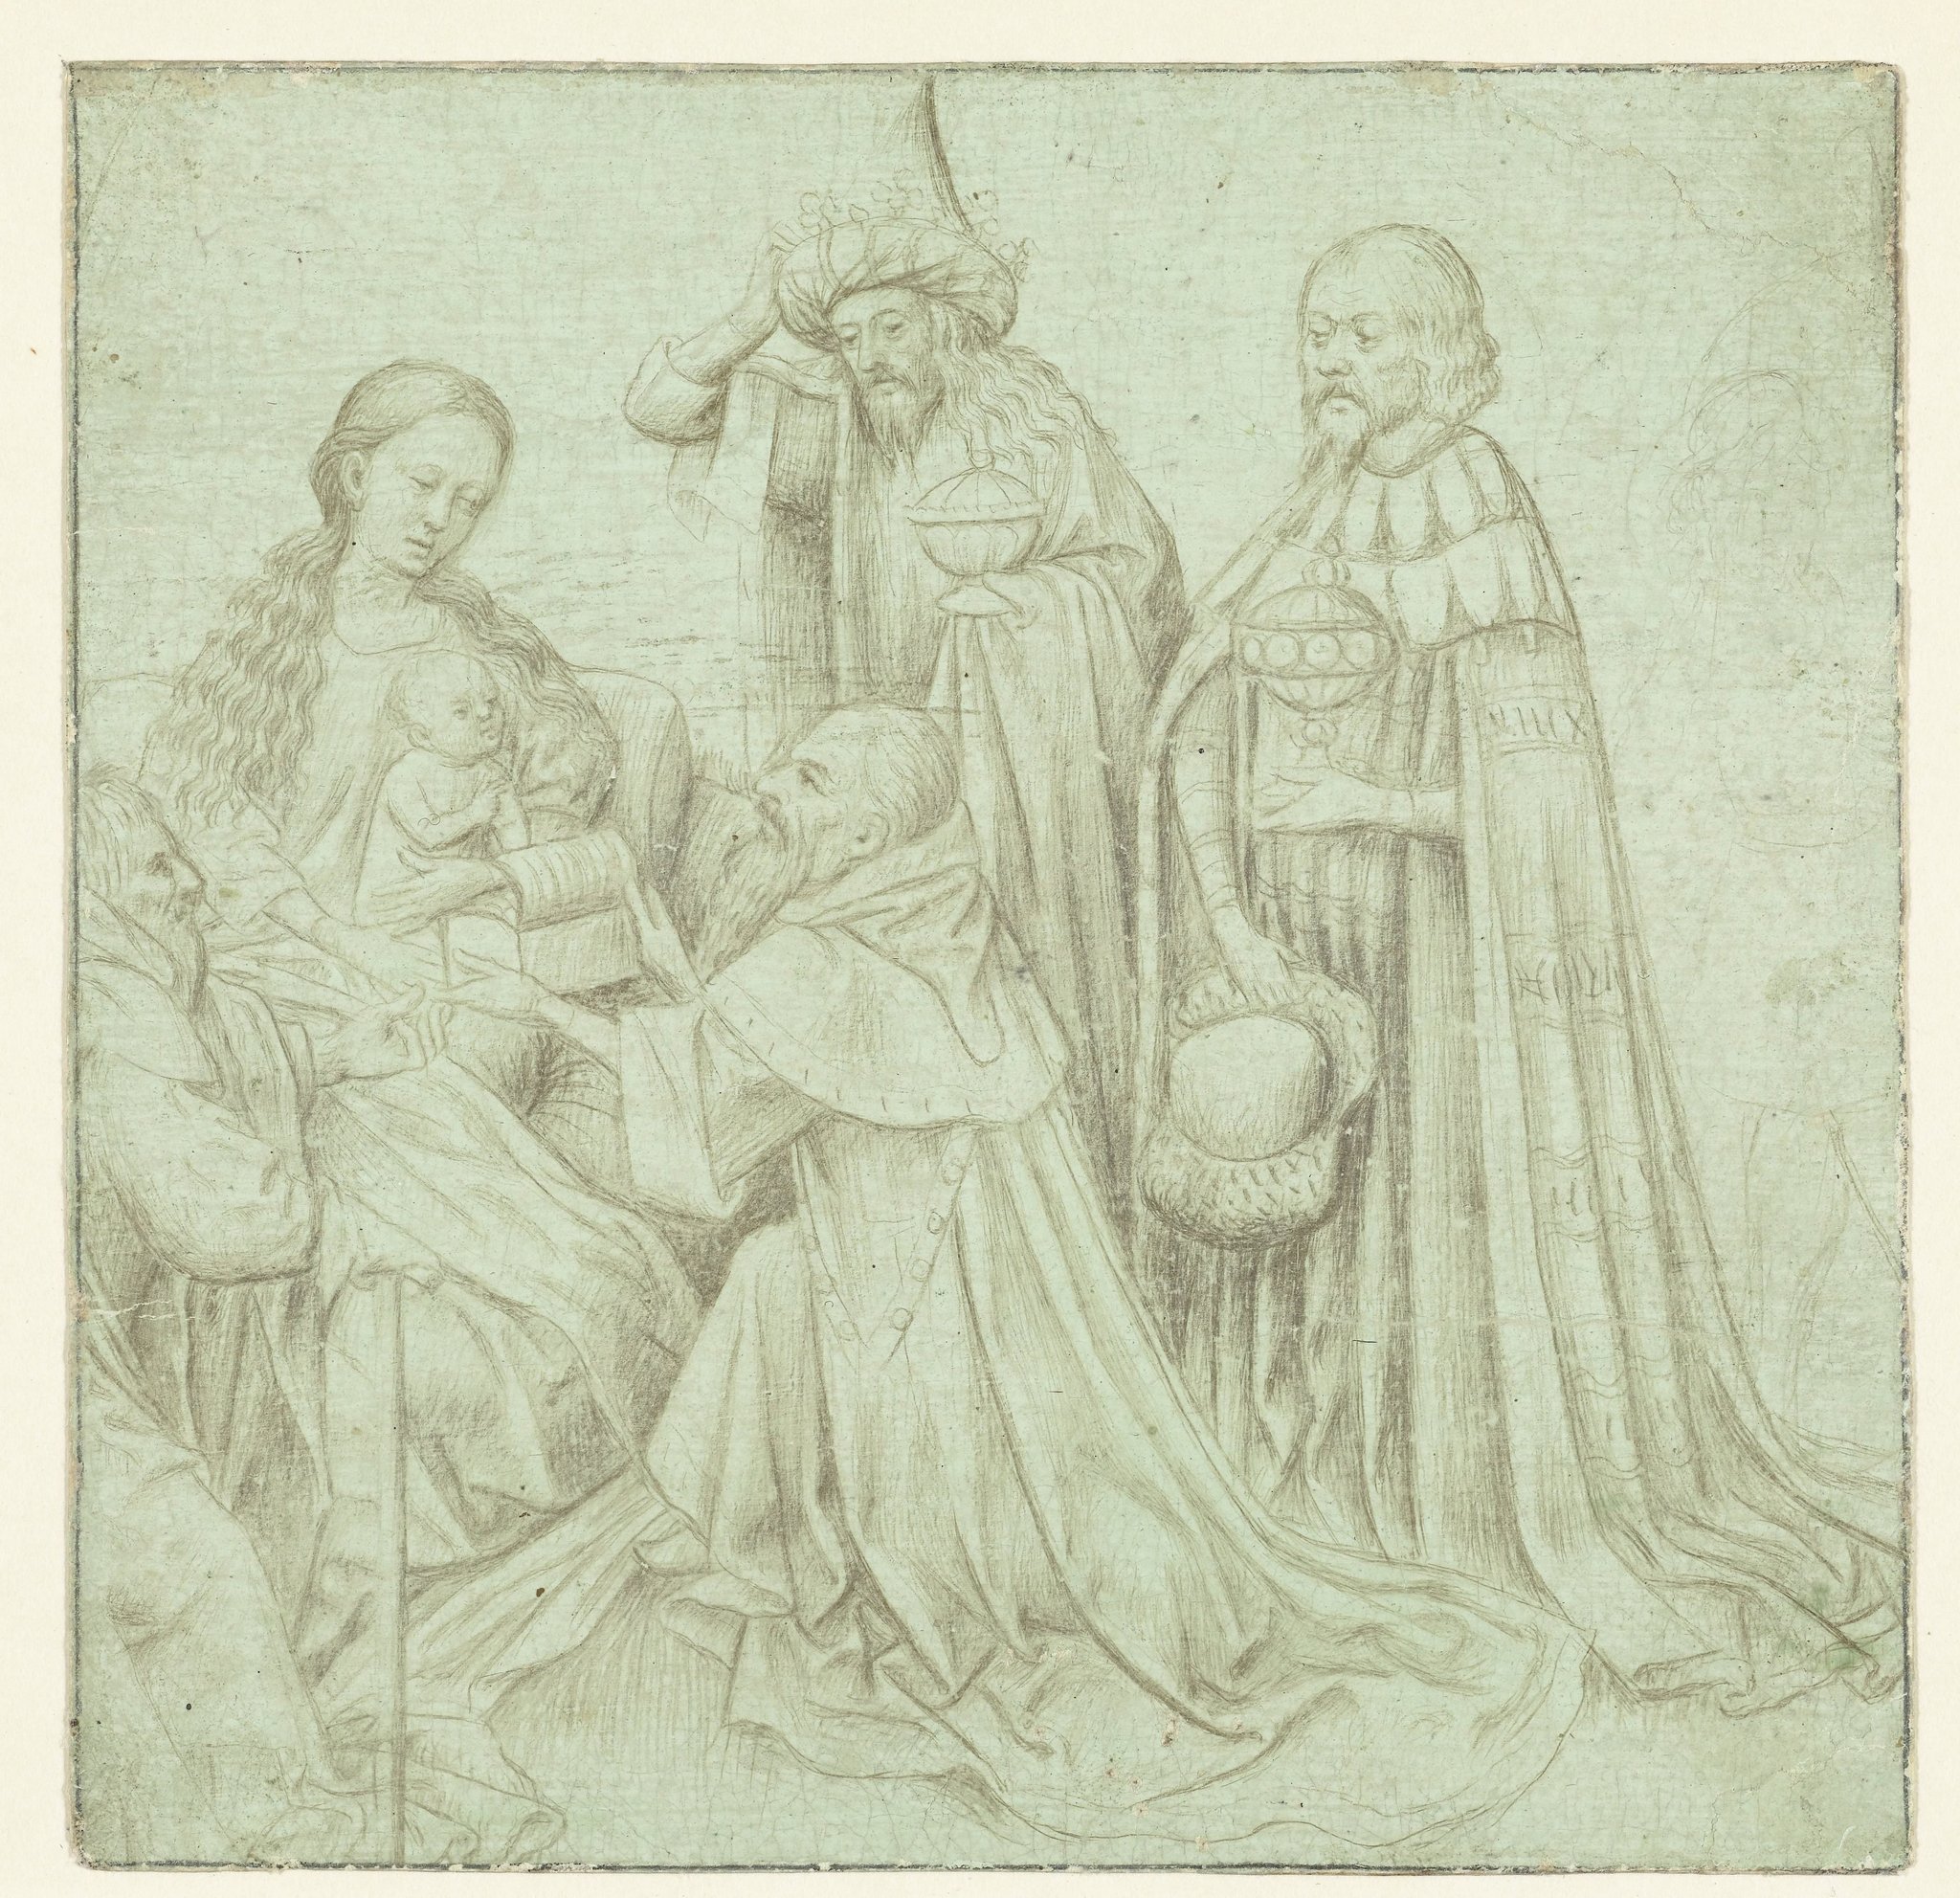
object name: drawing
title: The Adoration of the Magi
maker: jan van eyck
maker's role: draughtsman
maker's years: 1390-1441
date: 1430-1440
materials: paper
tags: adoration of the kings: the wise men present their gifts to the christ-child (gold, frankincense and myrrh)